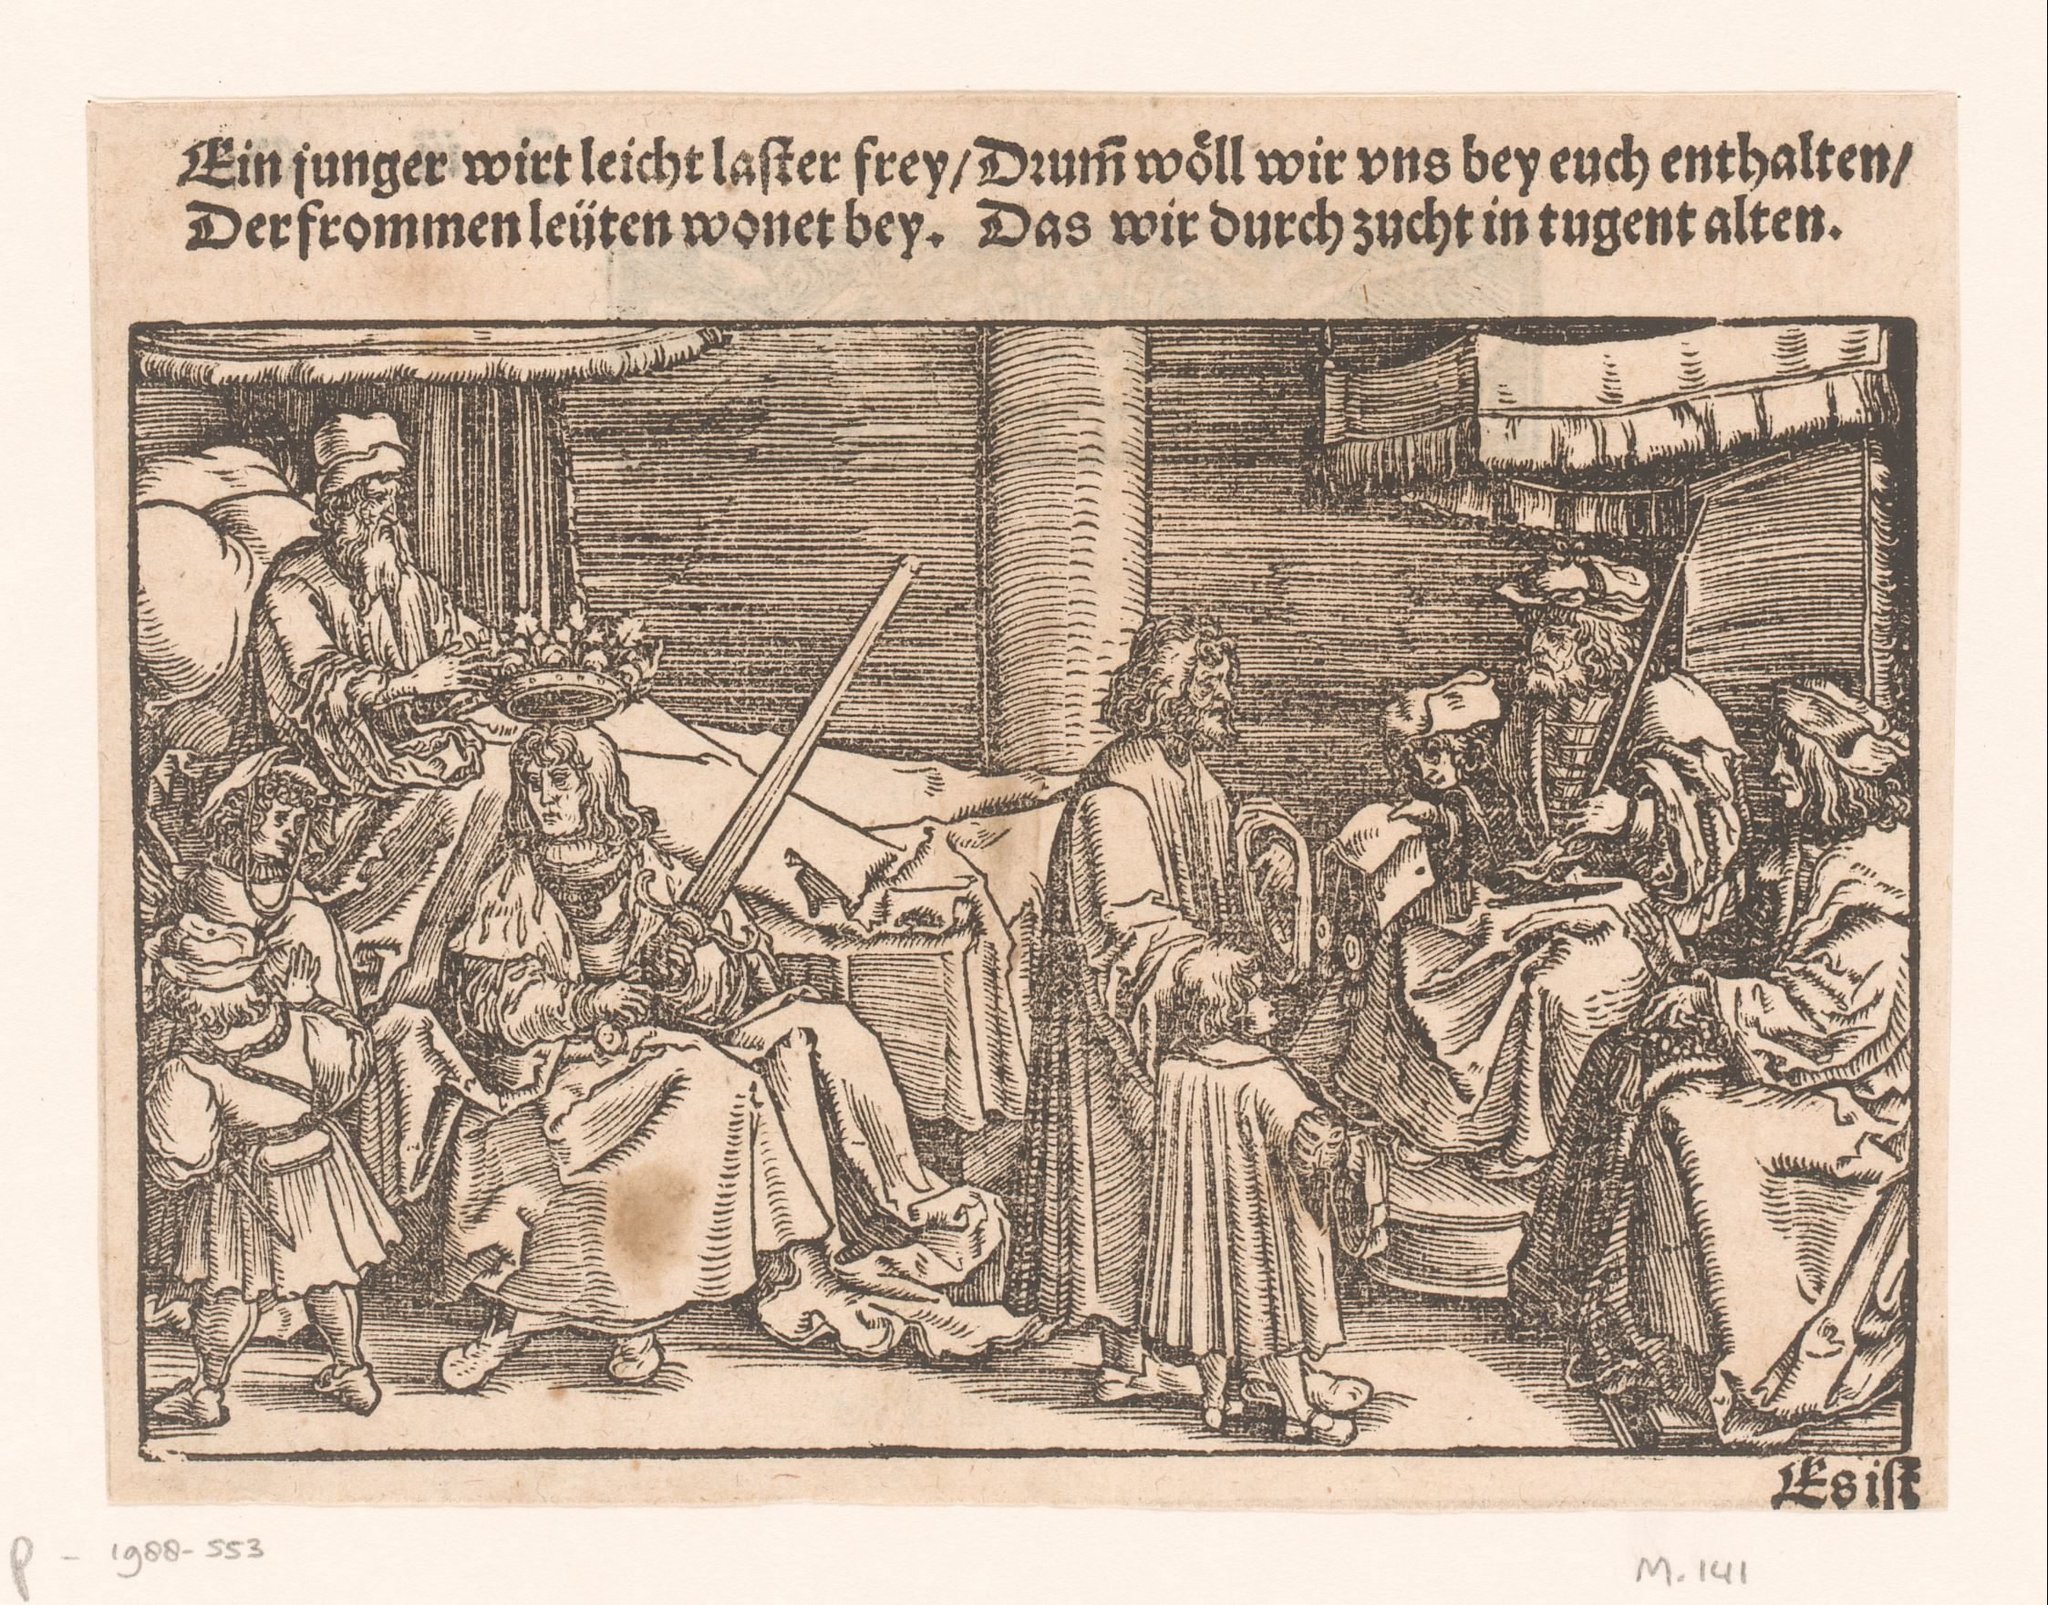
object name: book illustration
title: Stervende man kroont zijn zoon en een rechtspraak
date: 1532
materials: paper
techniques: woodcut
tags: literature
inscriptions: collector's mark: Lugt 2228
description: Prent voor het eerst gebruikt in: Petrarca, Francesco. Von der Artzney bayder Glück. Augsburg: Heinrich Steiner, 1532.